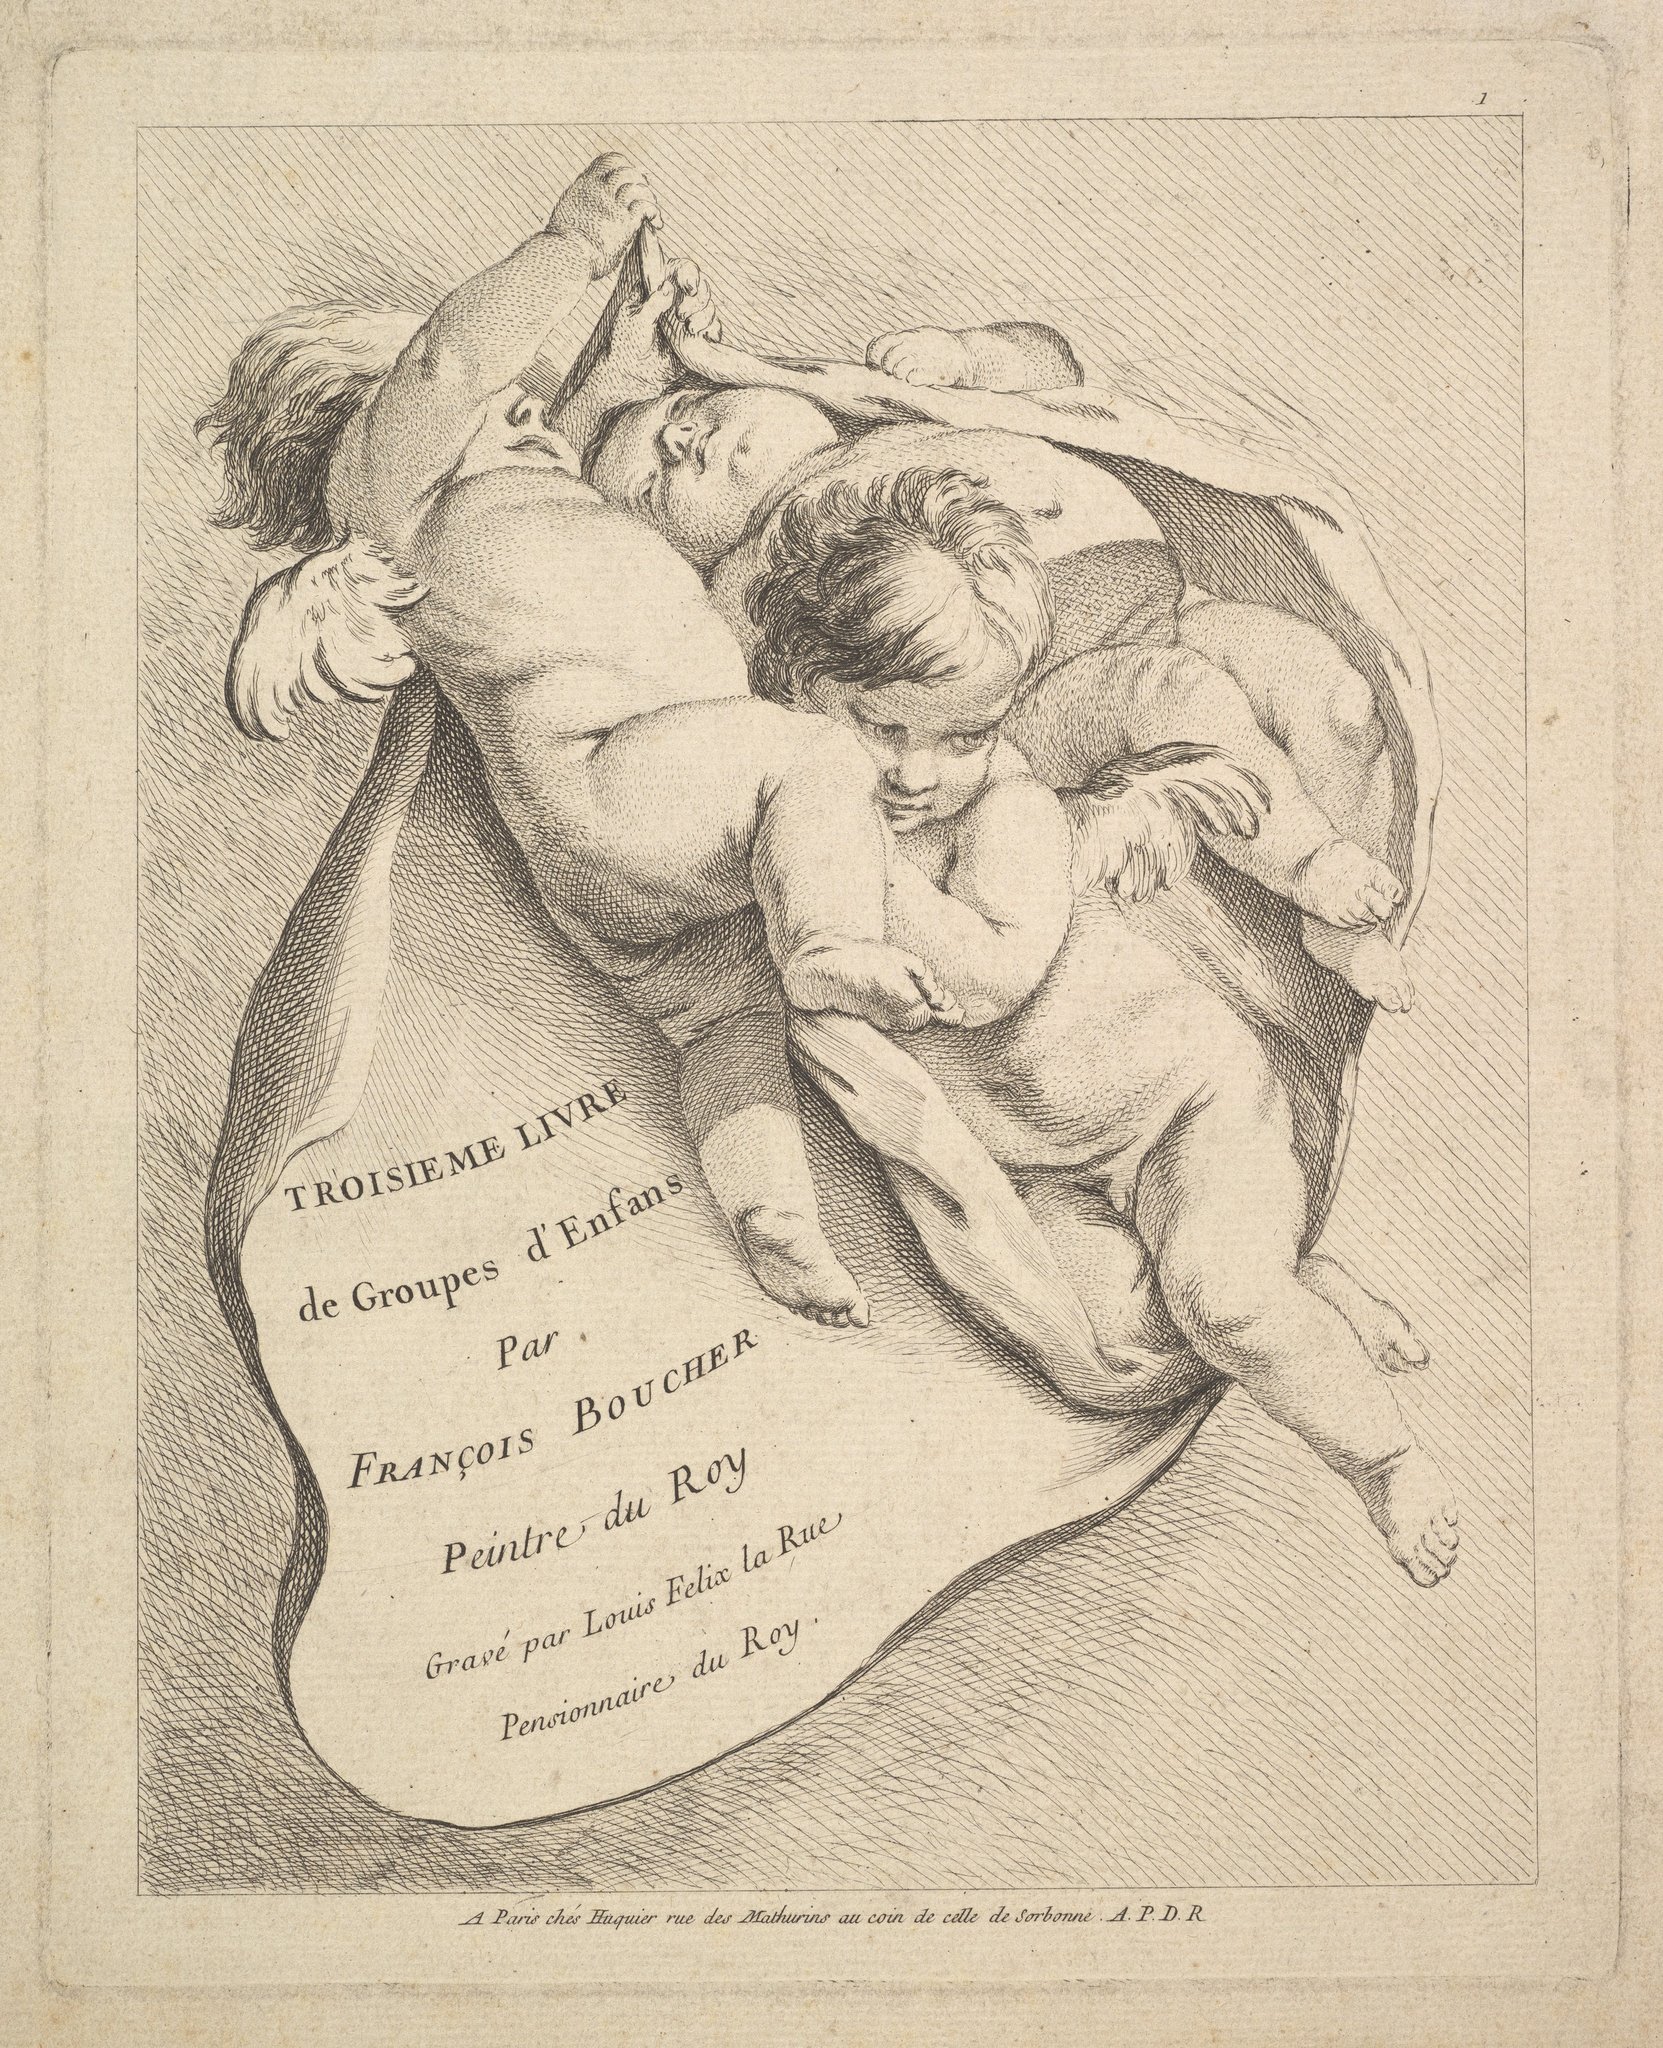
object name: print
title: Frontispiece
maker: louis félix de la rue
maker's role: artist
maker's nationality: french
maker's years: 1731-1765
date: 1731-1765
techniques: engraving, etching